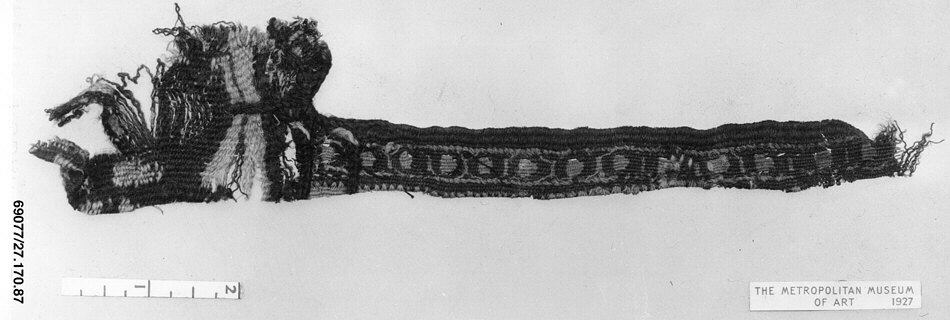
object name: textile fragment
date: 1201-1400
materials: wool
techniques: weave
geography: egypt